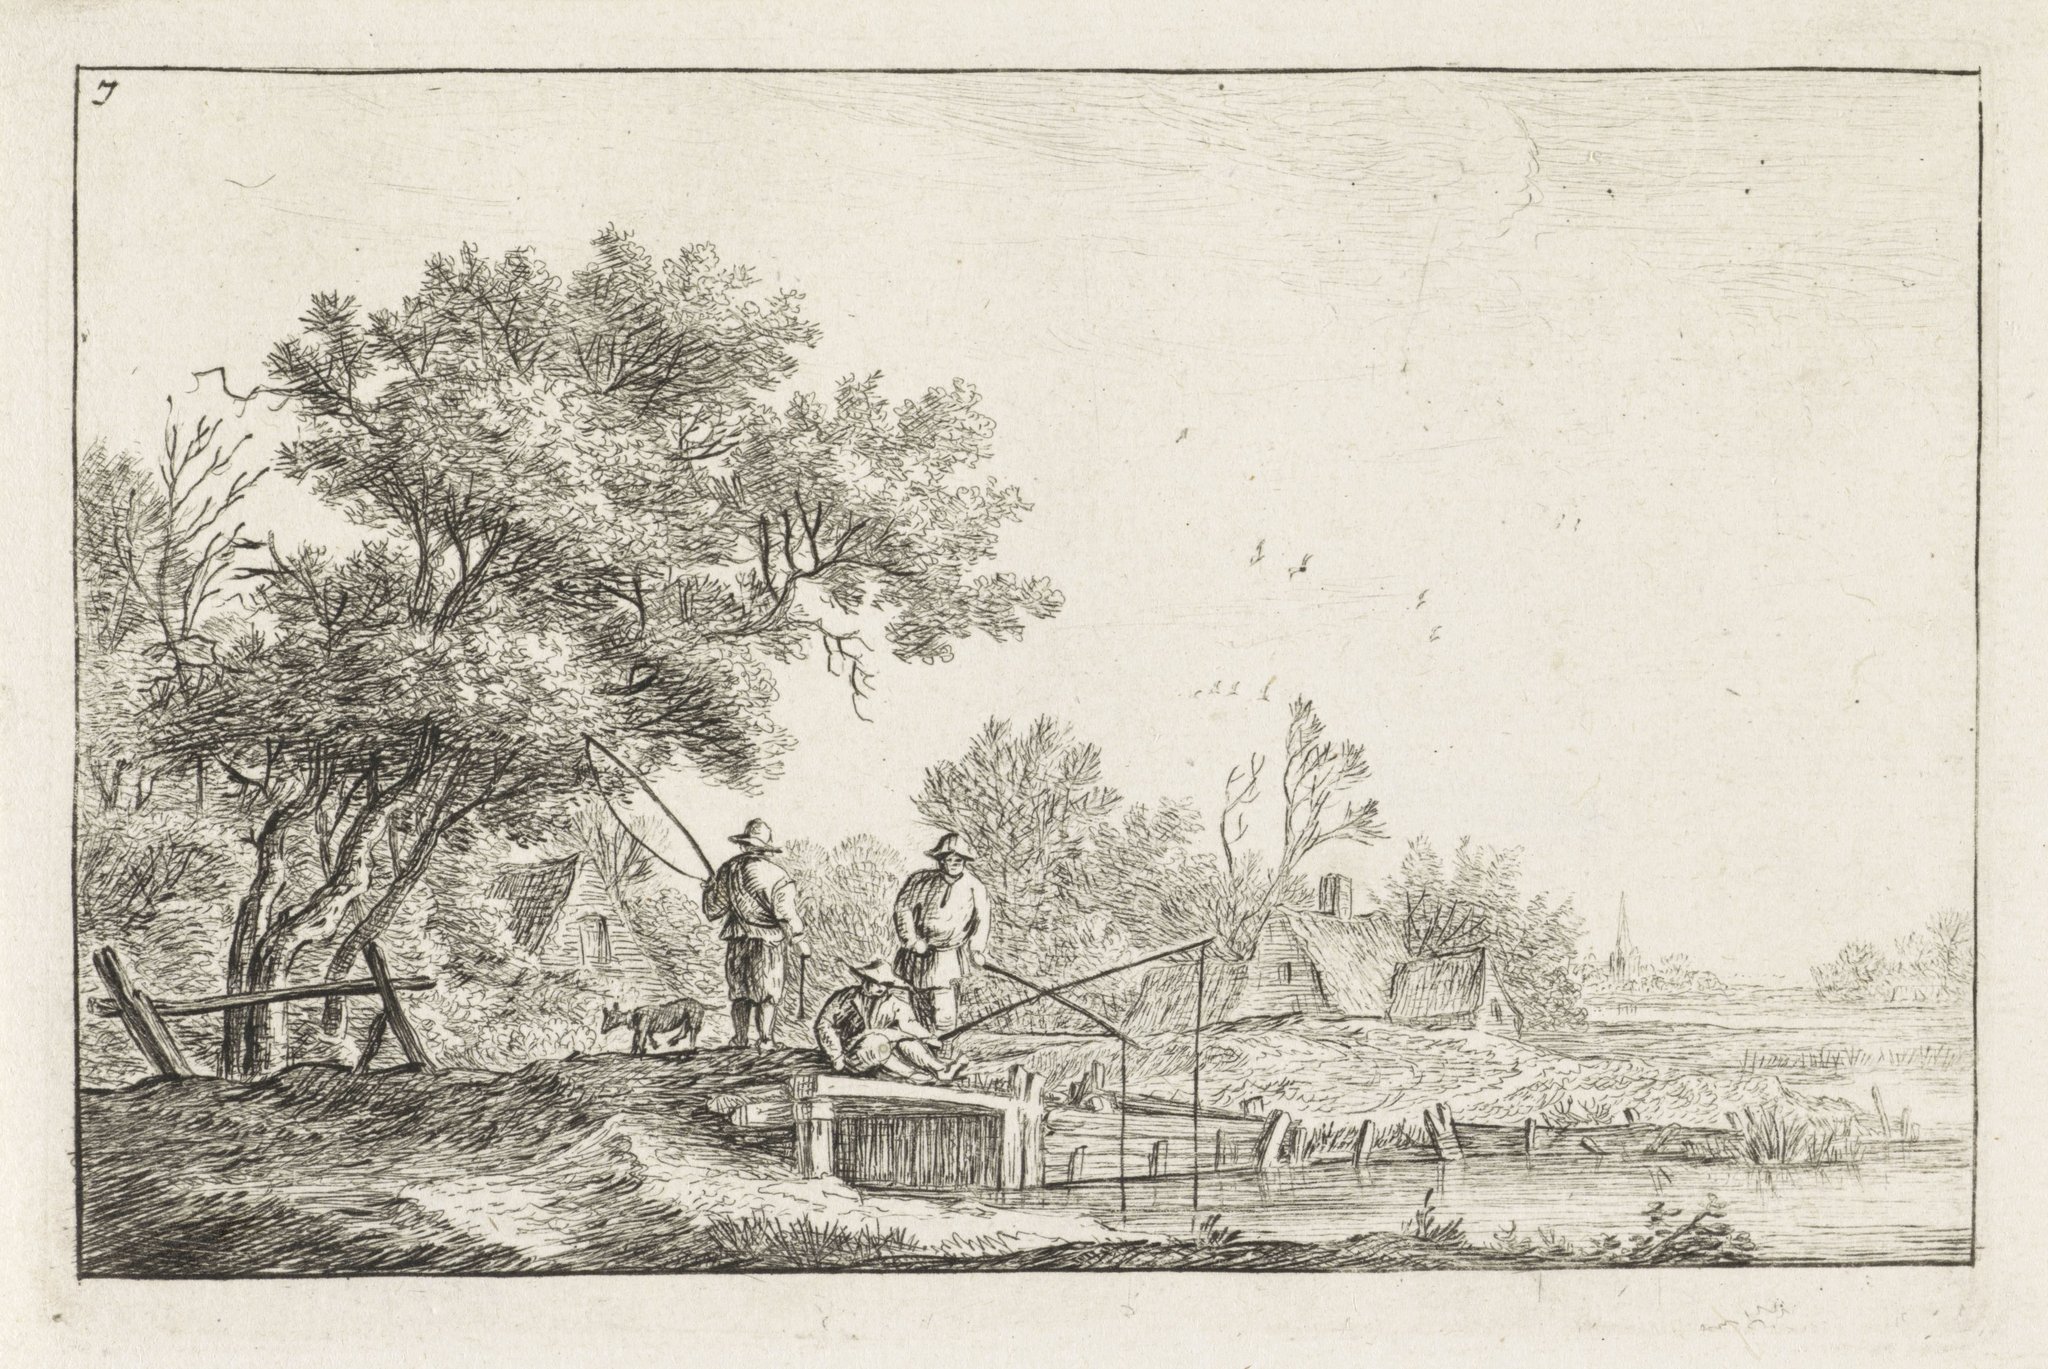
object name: print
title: Landschappen met bebouwing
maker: anthonie waterloo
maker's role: draughtsman, painter, print maker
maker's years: 1609-1690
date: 1630-1663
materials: paper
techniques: etching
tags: city-view, and landscape with man-made constructions, landscapes with waters, waterscapes, seascapes (in the temperate zone), bridge, fisherman, dog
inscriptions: collector's mark: Lugt 2165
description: Op een bruggetje over een rivier zijn drie vissers te zien. Ze worden vergezeld door een hond. Achter hen staan enkele huizen en in de verte is een kerk weergegeven.